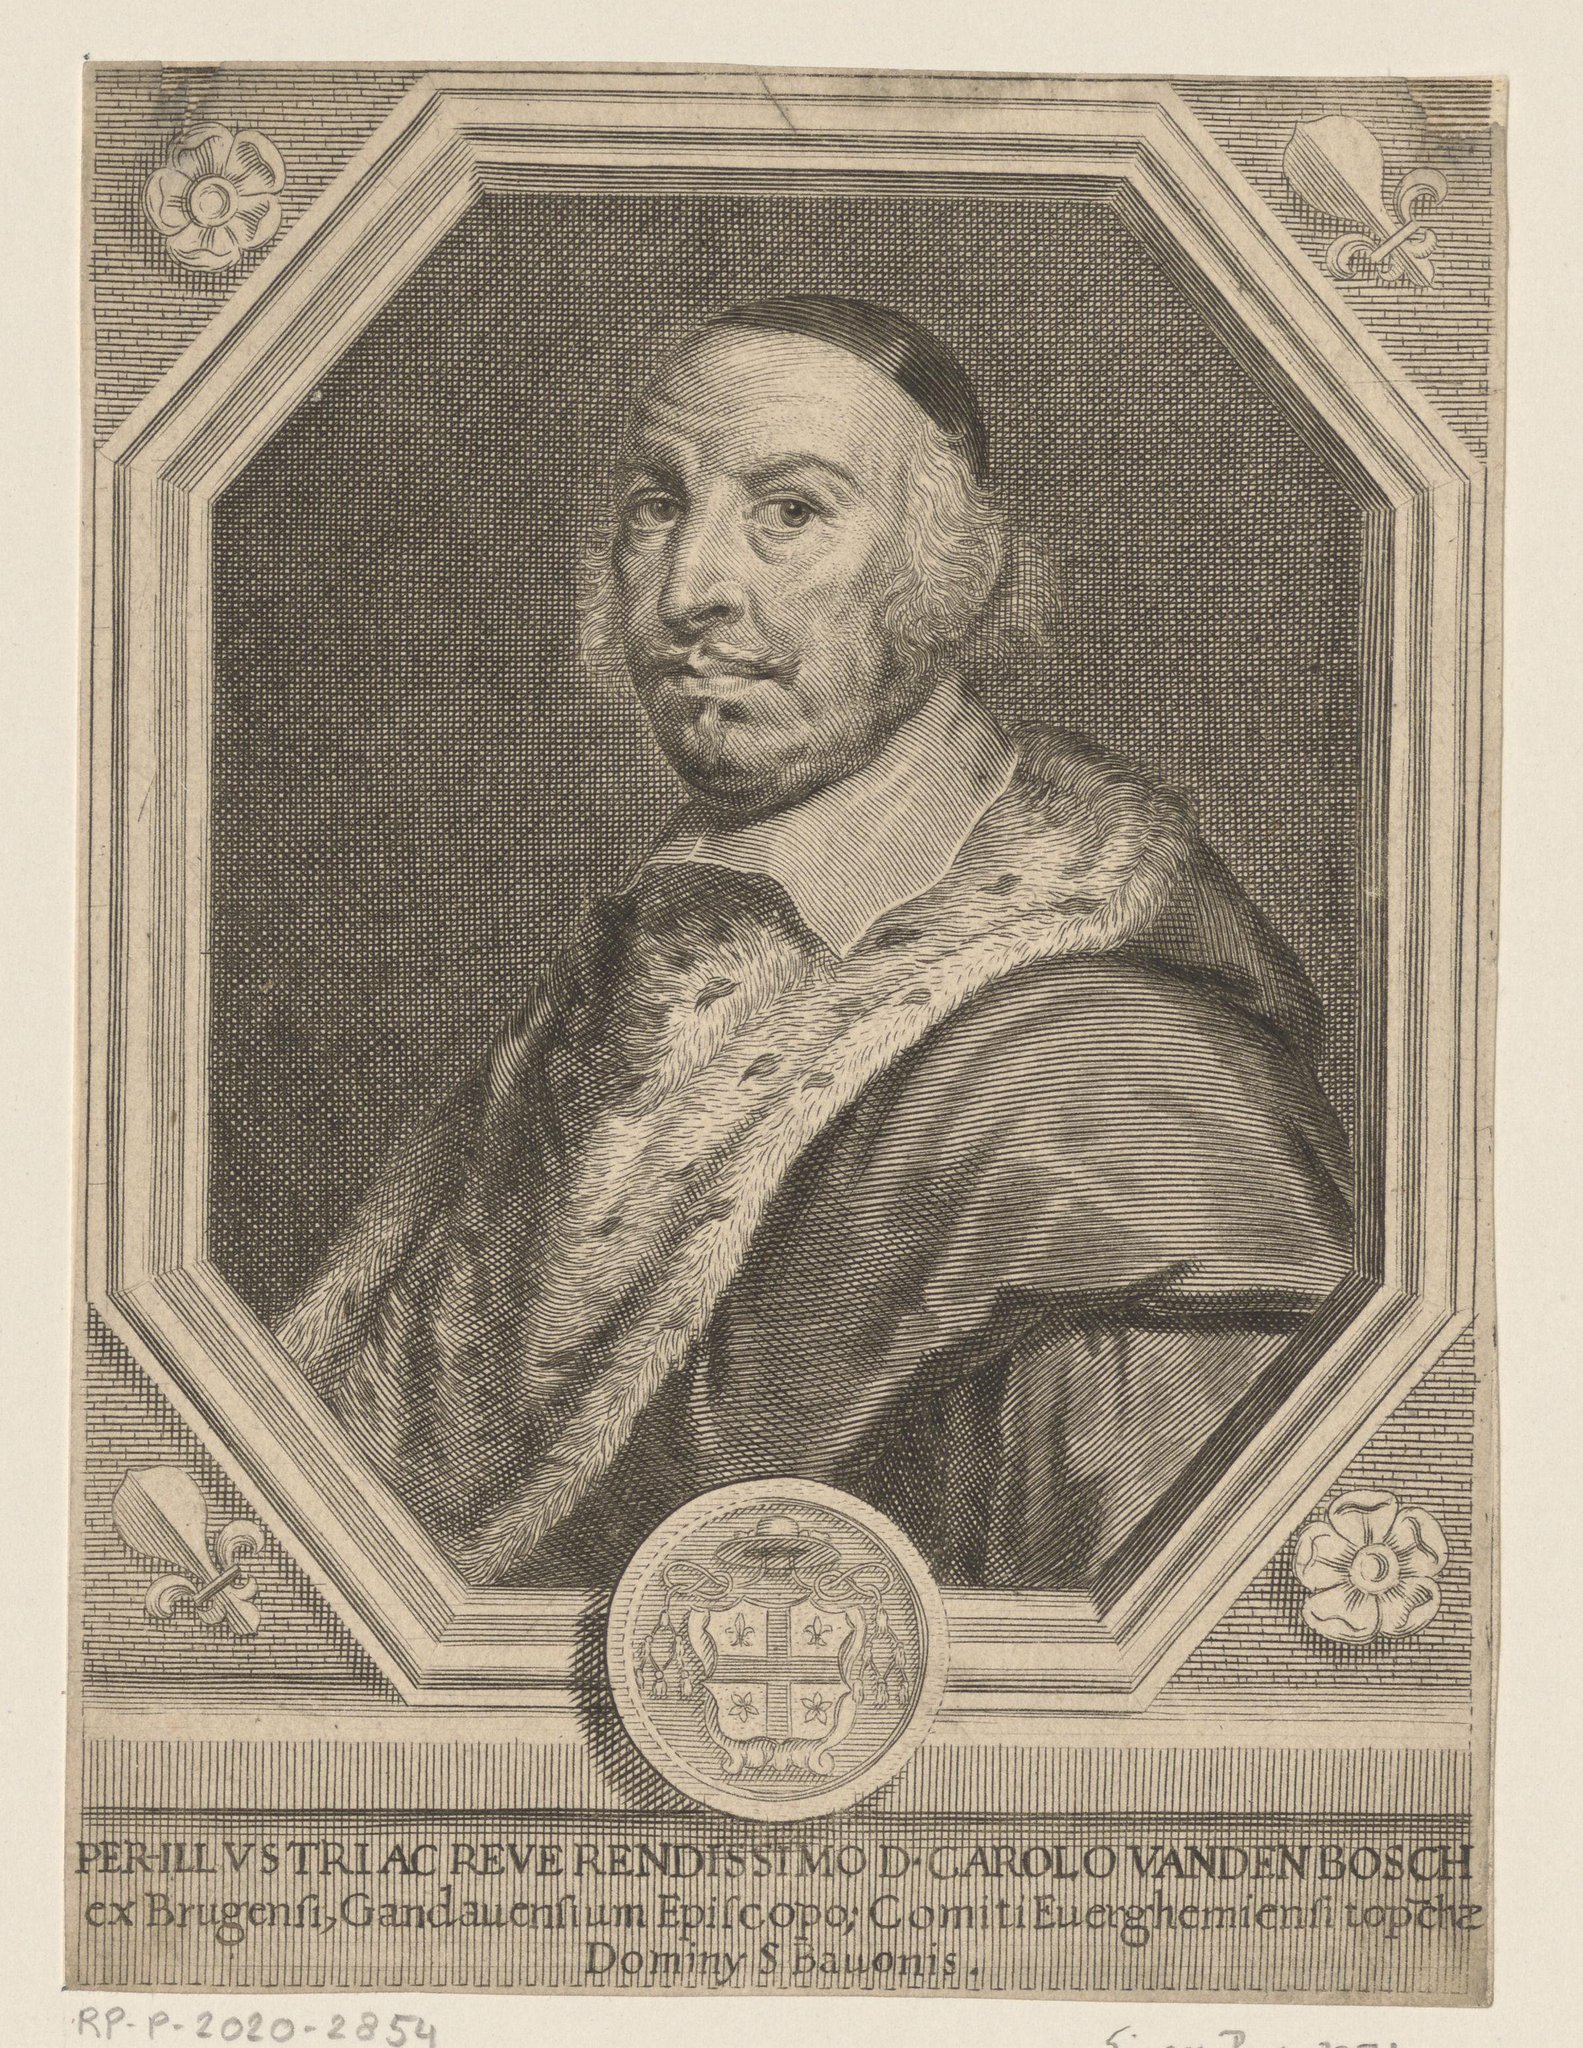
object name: print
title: Portret van Karel van den Bosch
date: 1660-1699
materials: paper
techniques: engraving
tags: brussels, ghent, karel van den bosch, archbishop, bishop, etc. (roman catholic), historical persons, armorial bearing, heraldry